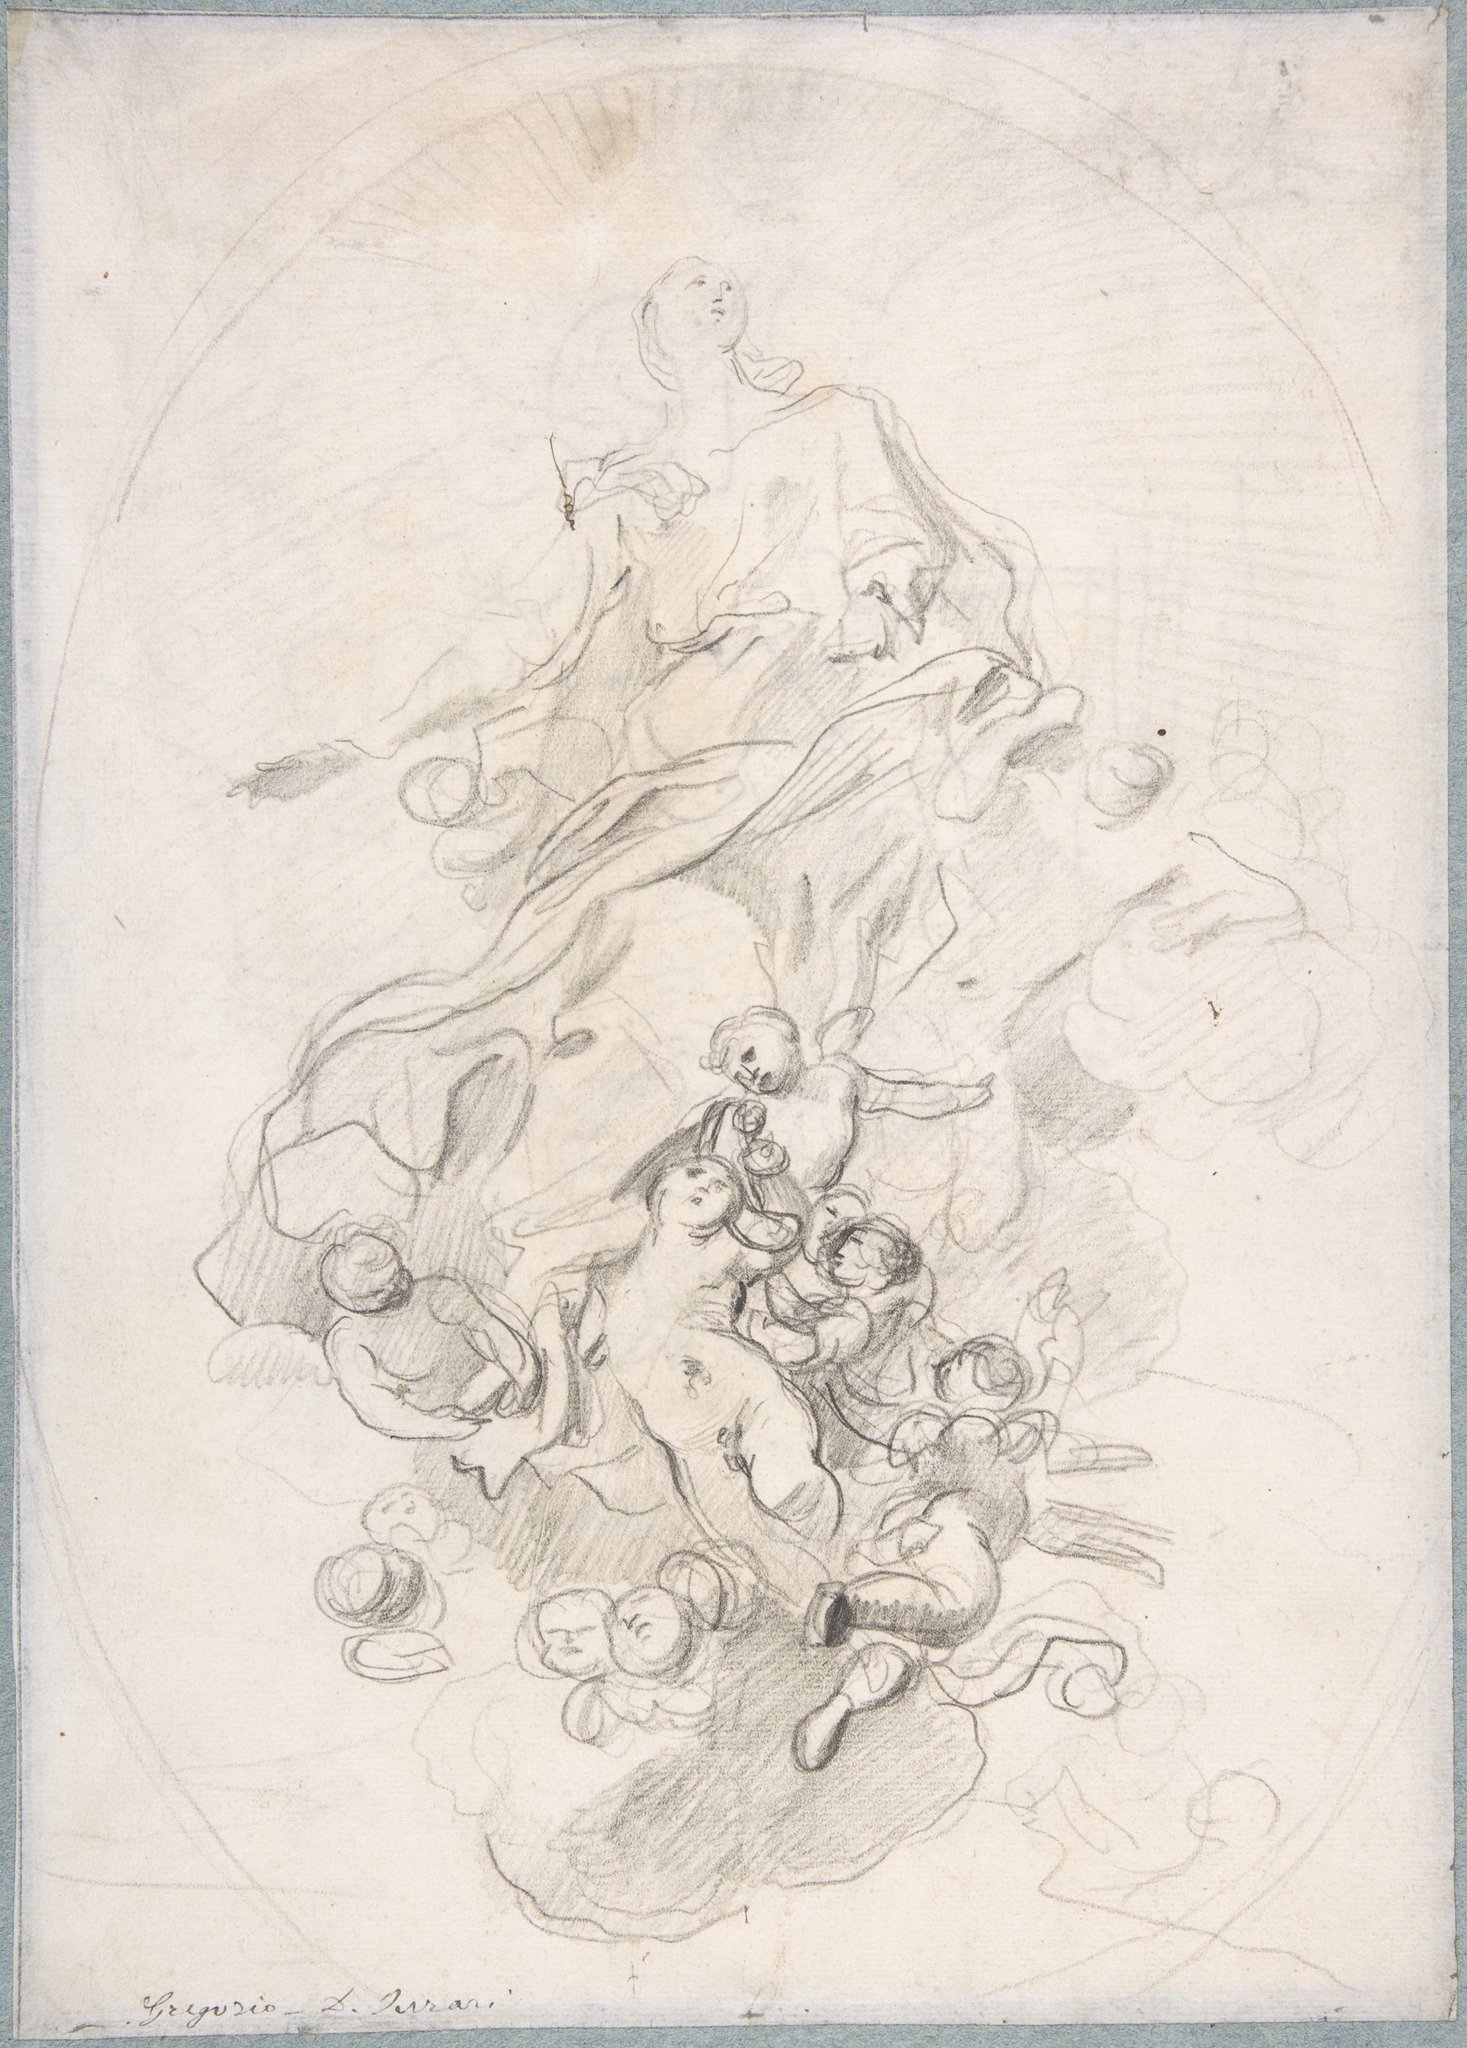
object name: drawing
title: The Assumption of the Virgin (recto); Architectural Notations (verso)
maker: lorenzo de' ferrari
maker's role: artist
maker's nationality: italian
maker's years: 1680-1744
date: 1680-1744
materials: chalk, ink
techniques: pen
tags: angels,virgin mary,assumption of the virgin